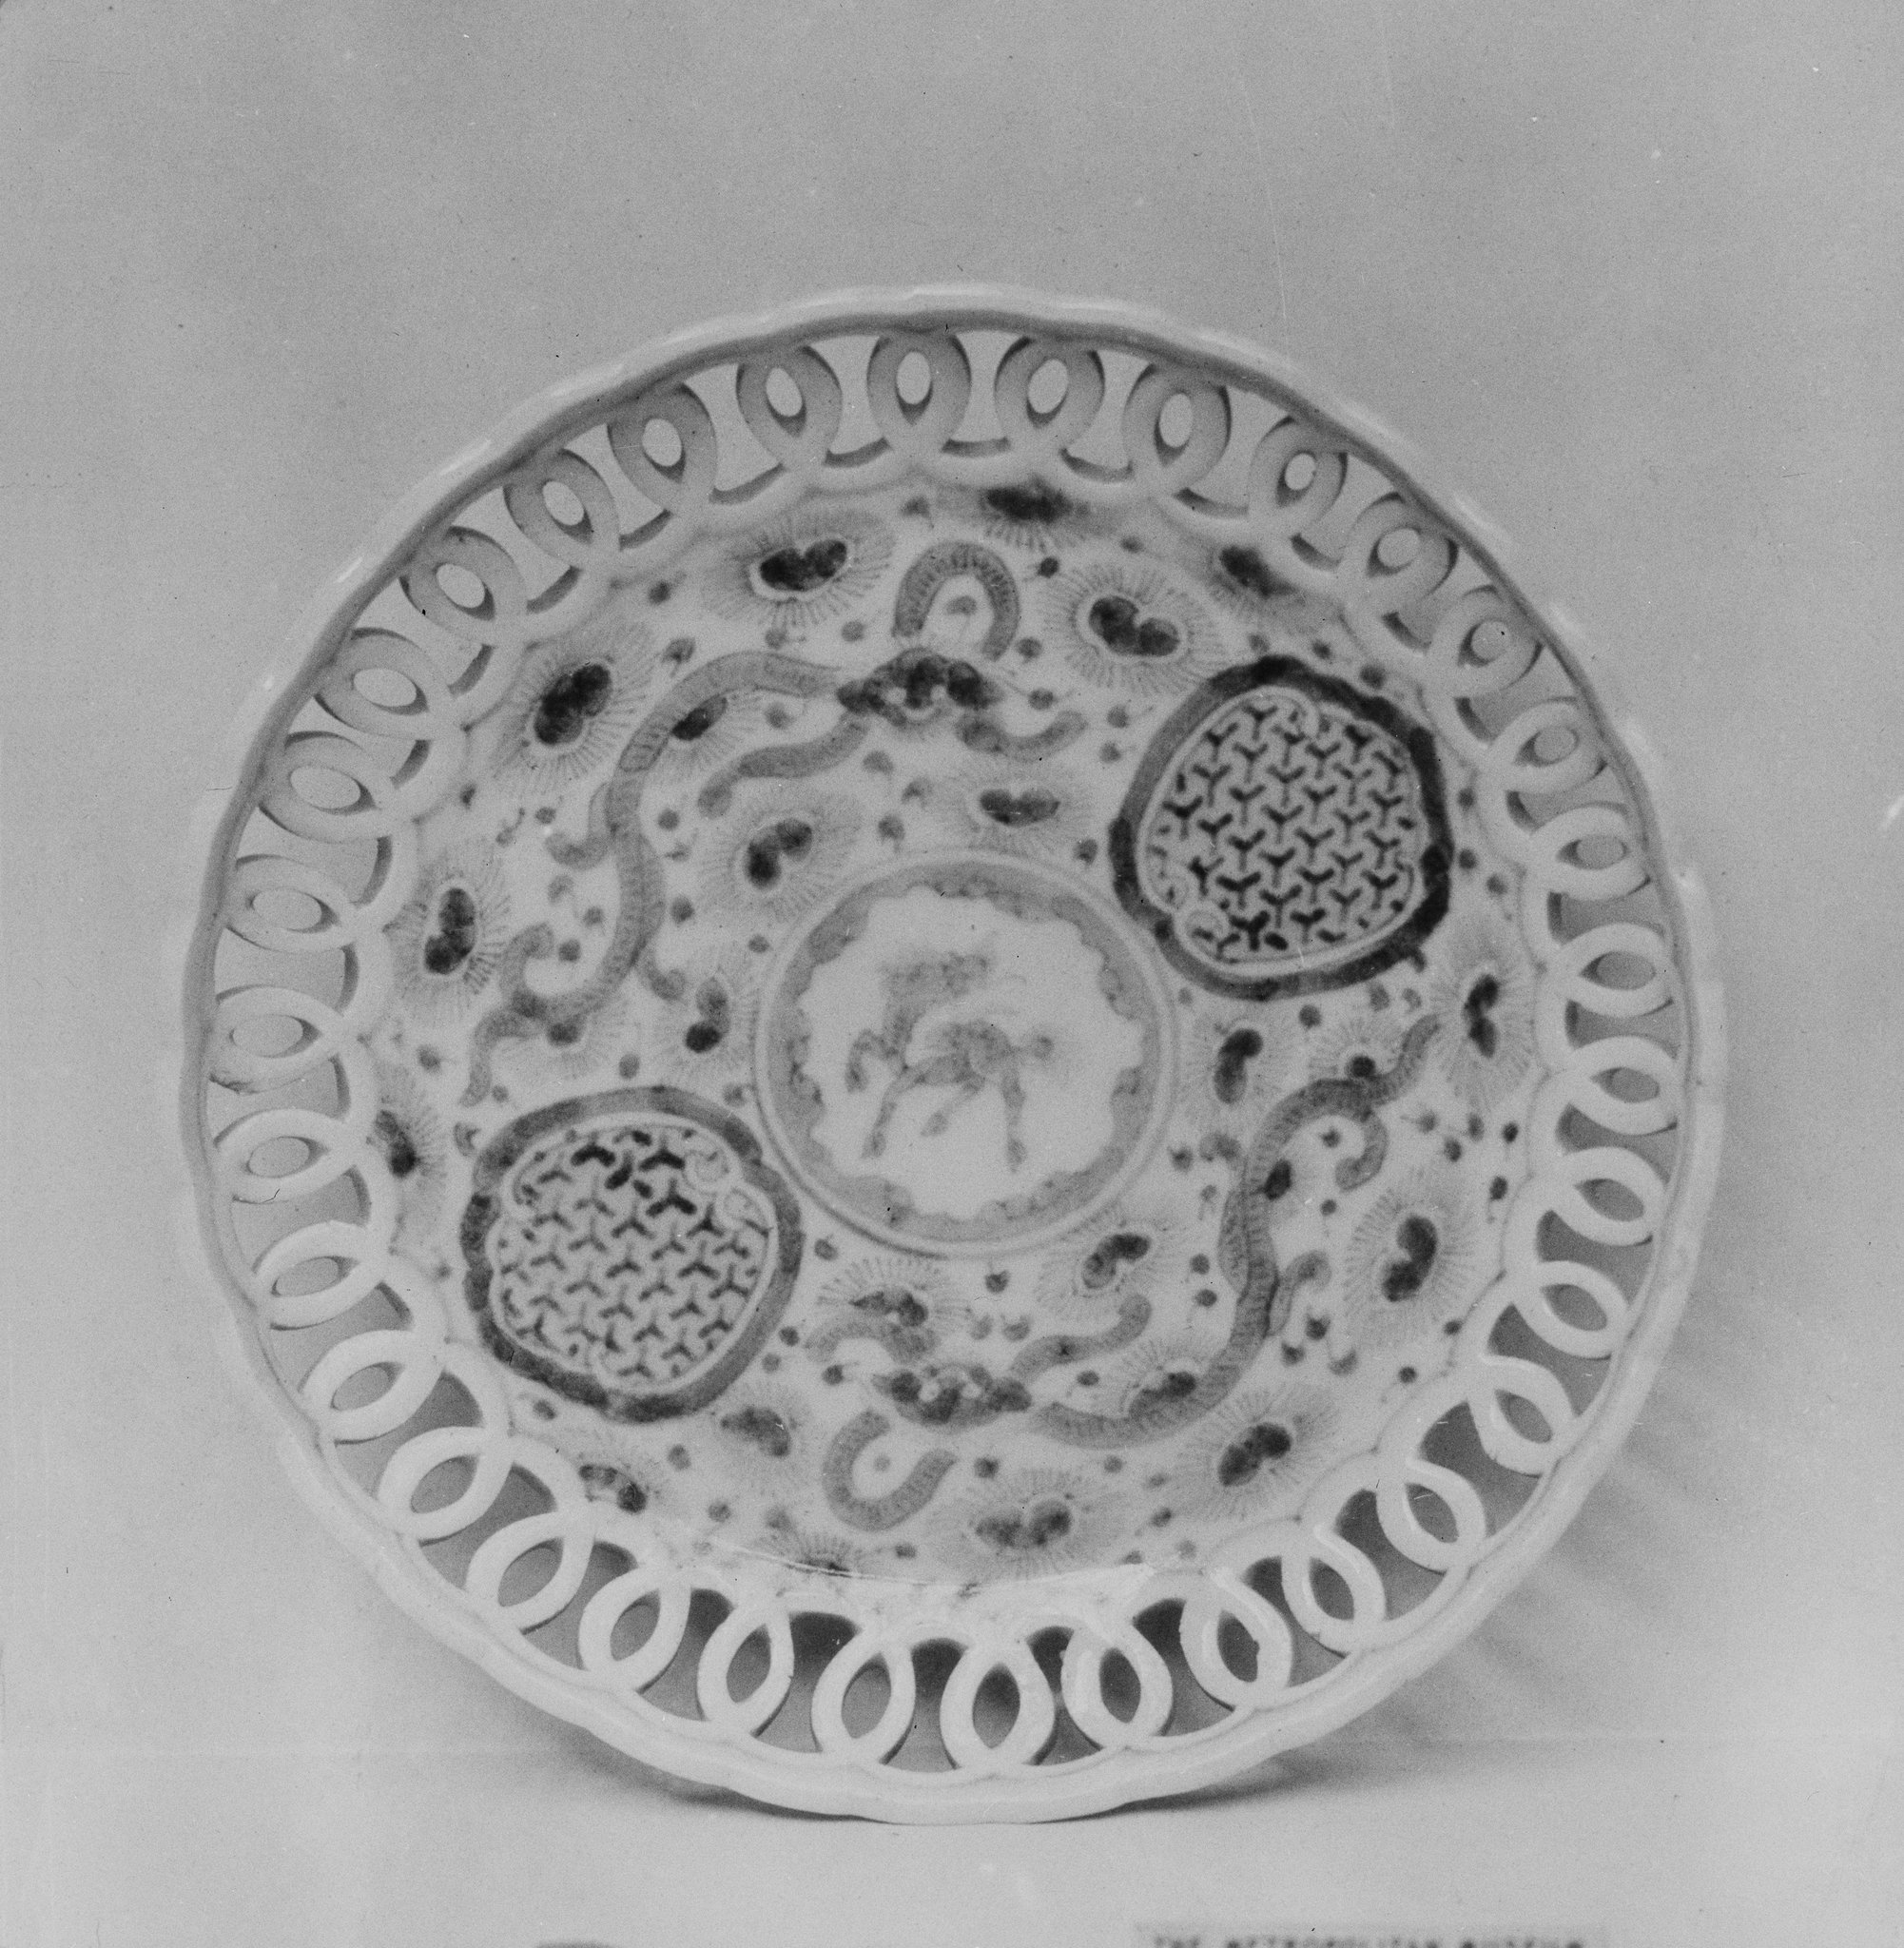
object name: plate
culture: japanese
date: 1820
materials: enamel, porcelain